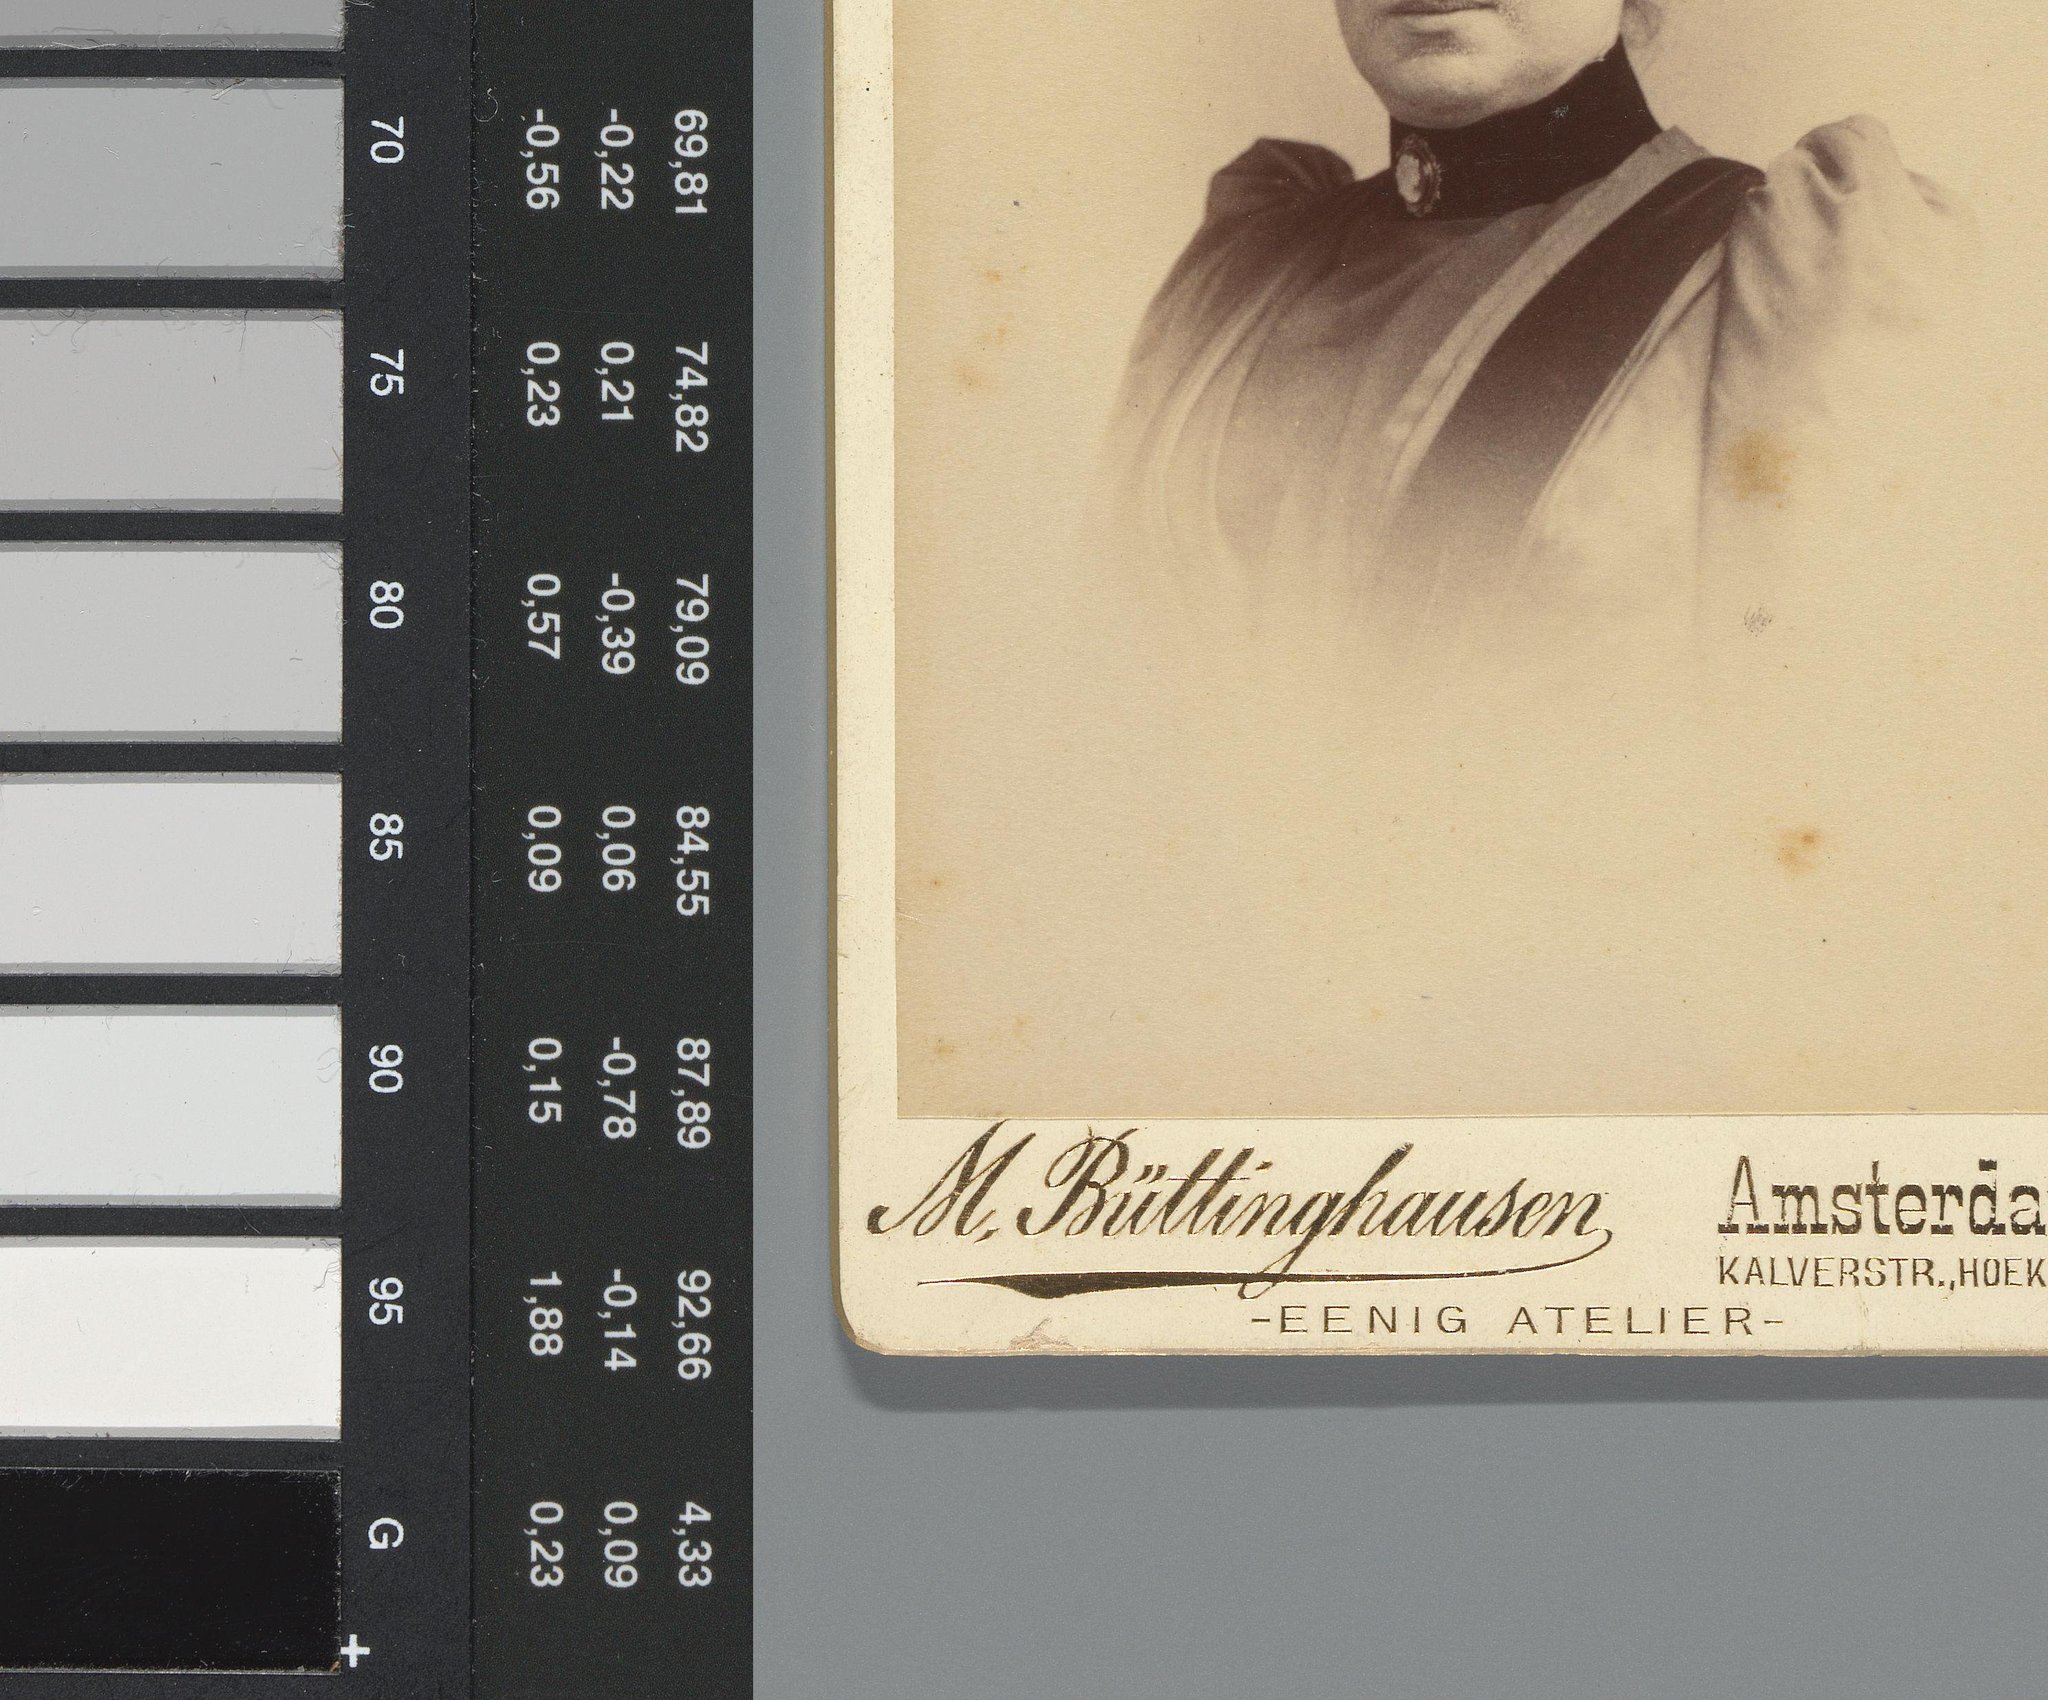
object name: carte de visite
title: Portret van Carolina Frederika Holle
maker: max büttinghausen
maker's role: fotograaf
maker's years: 1847-1906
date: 1870-1890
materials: cardboard, photographic support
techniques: albumen print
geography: amsterdam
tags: amsterdam, carolina frederika van den berg-holle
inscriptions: inscription: ‘C.F van den Berg- / Holle’, name, inscription: ‘M. Büttinghausen / Amsterdam. / KALVERSTR., HOEKSPUI / EENIG ATELIER’